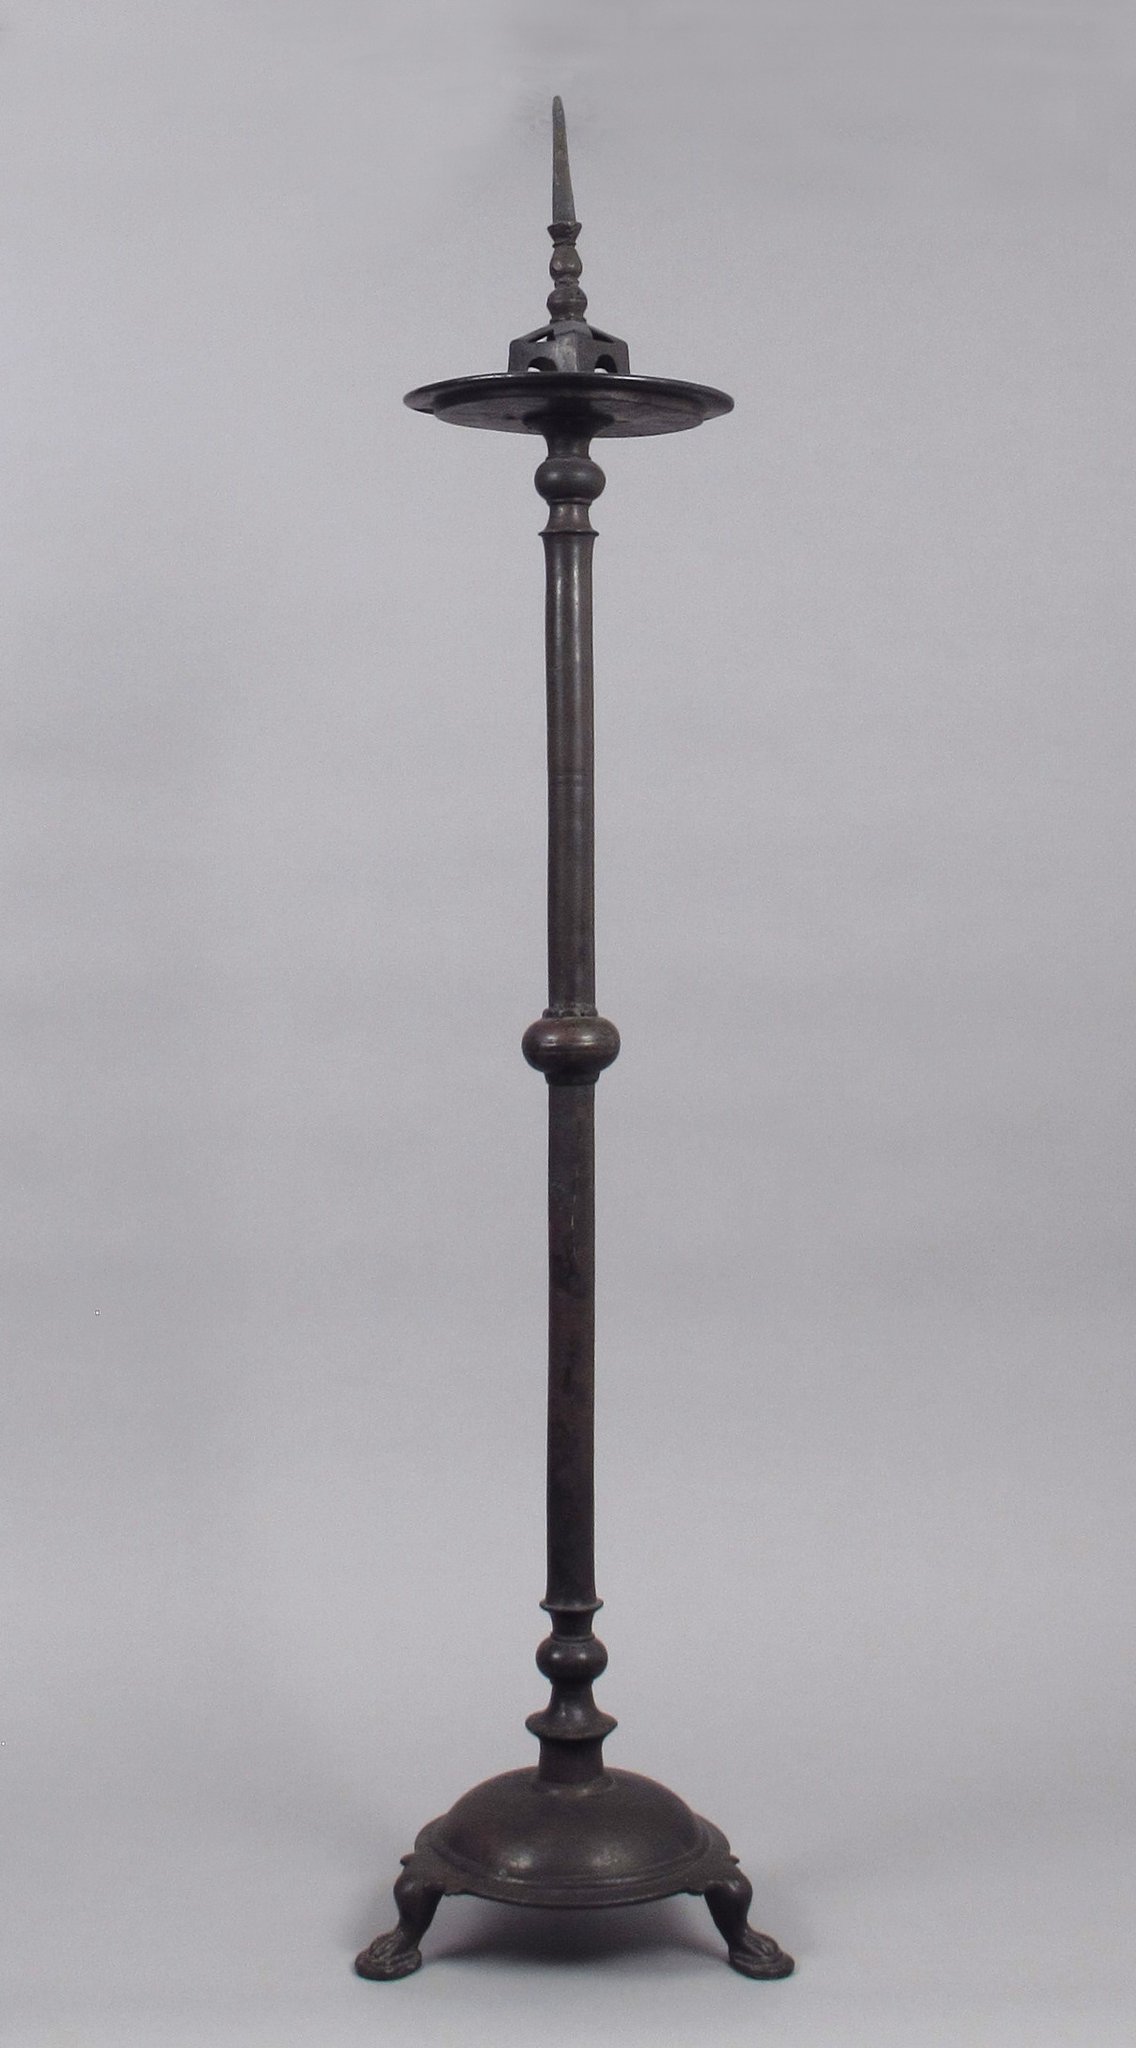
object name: lampstand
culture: byzantine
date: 500-800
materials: copper alloy